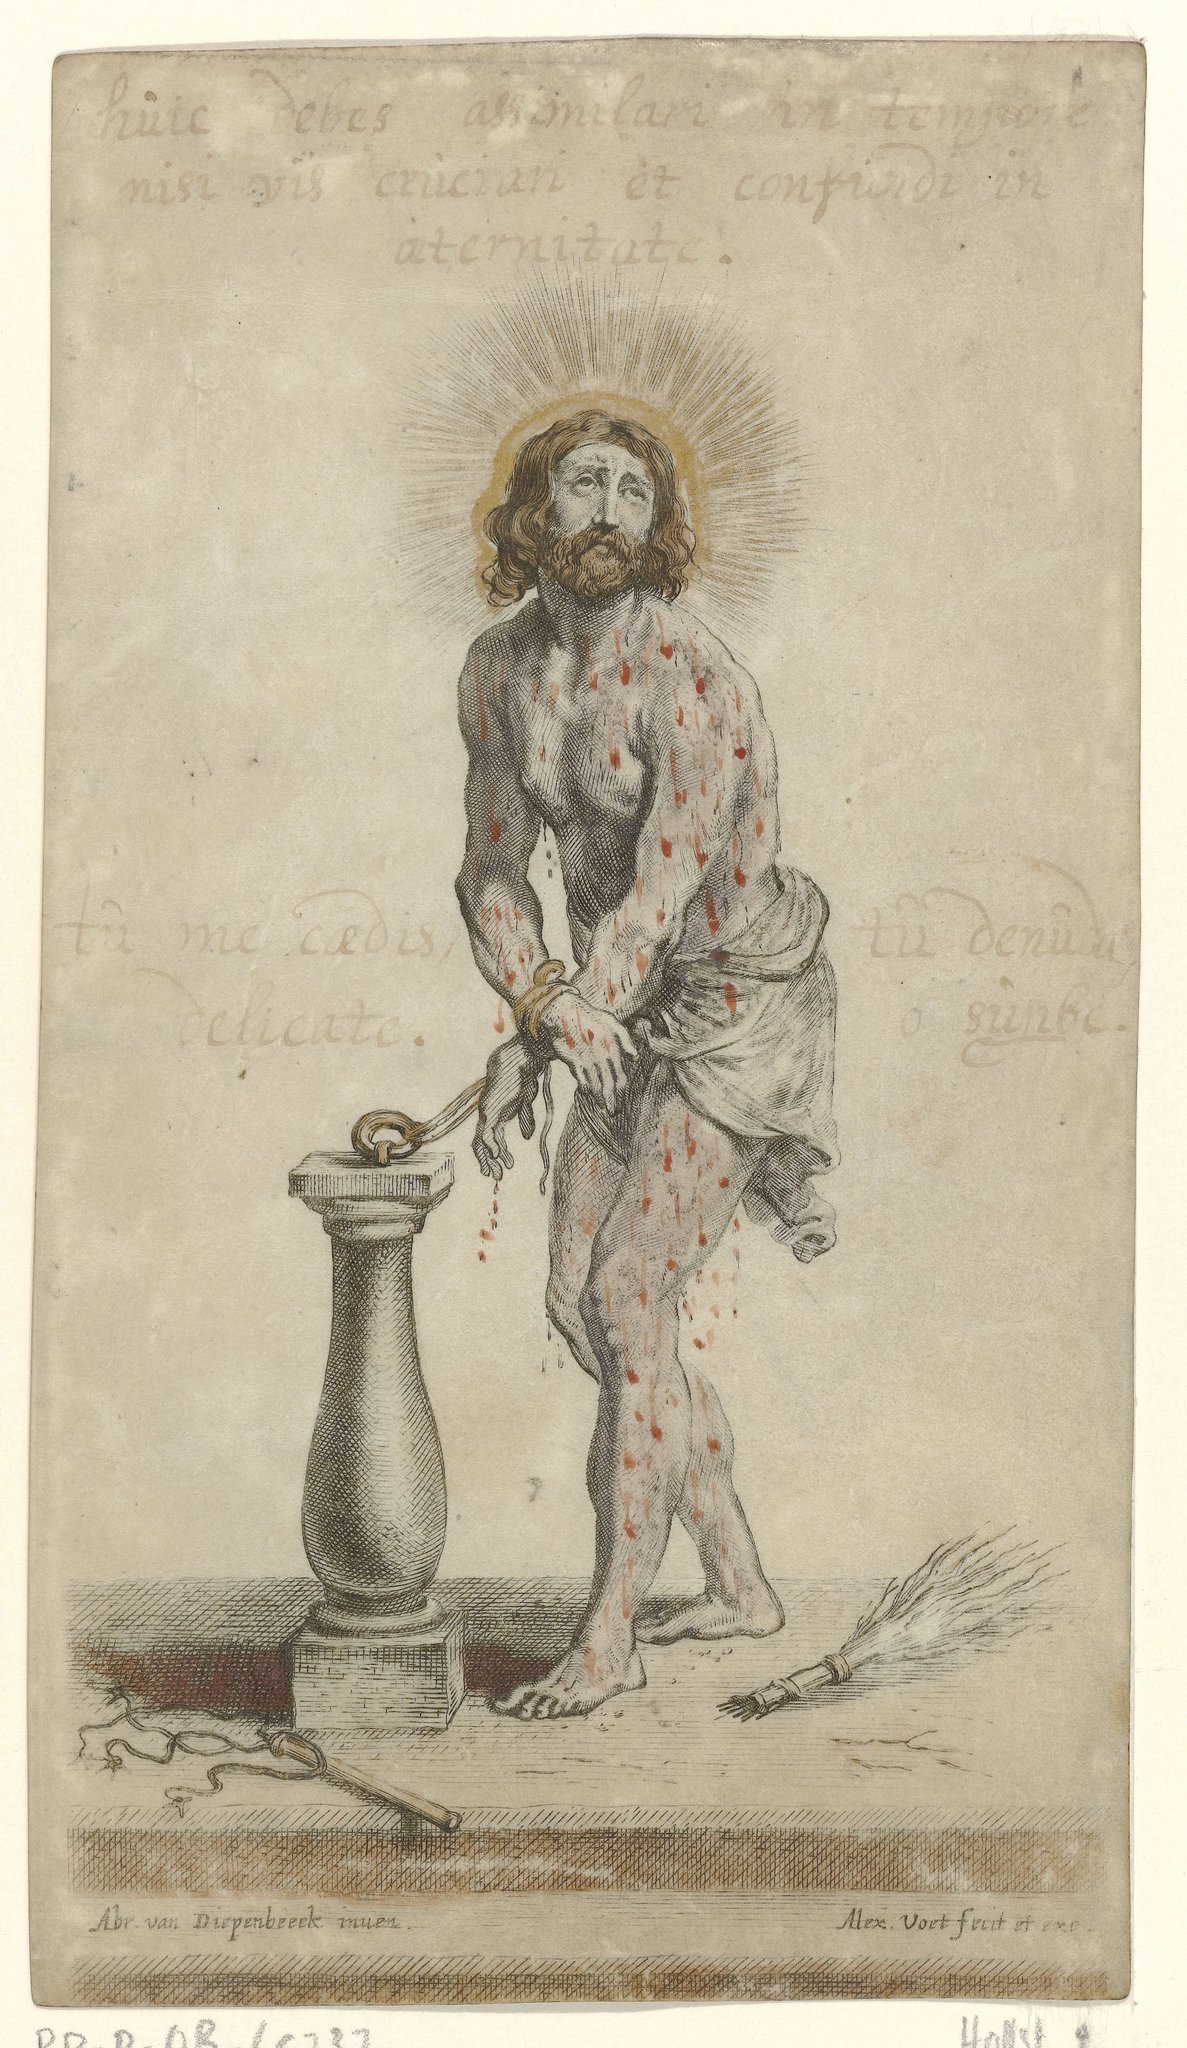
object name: print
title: Christus aan de geselpaal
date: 1628-1689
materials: parchment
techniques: engraving, hand coloring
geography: antwerp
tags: christ on the whipping-post (after the flagellation)